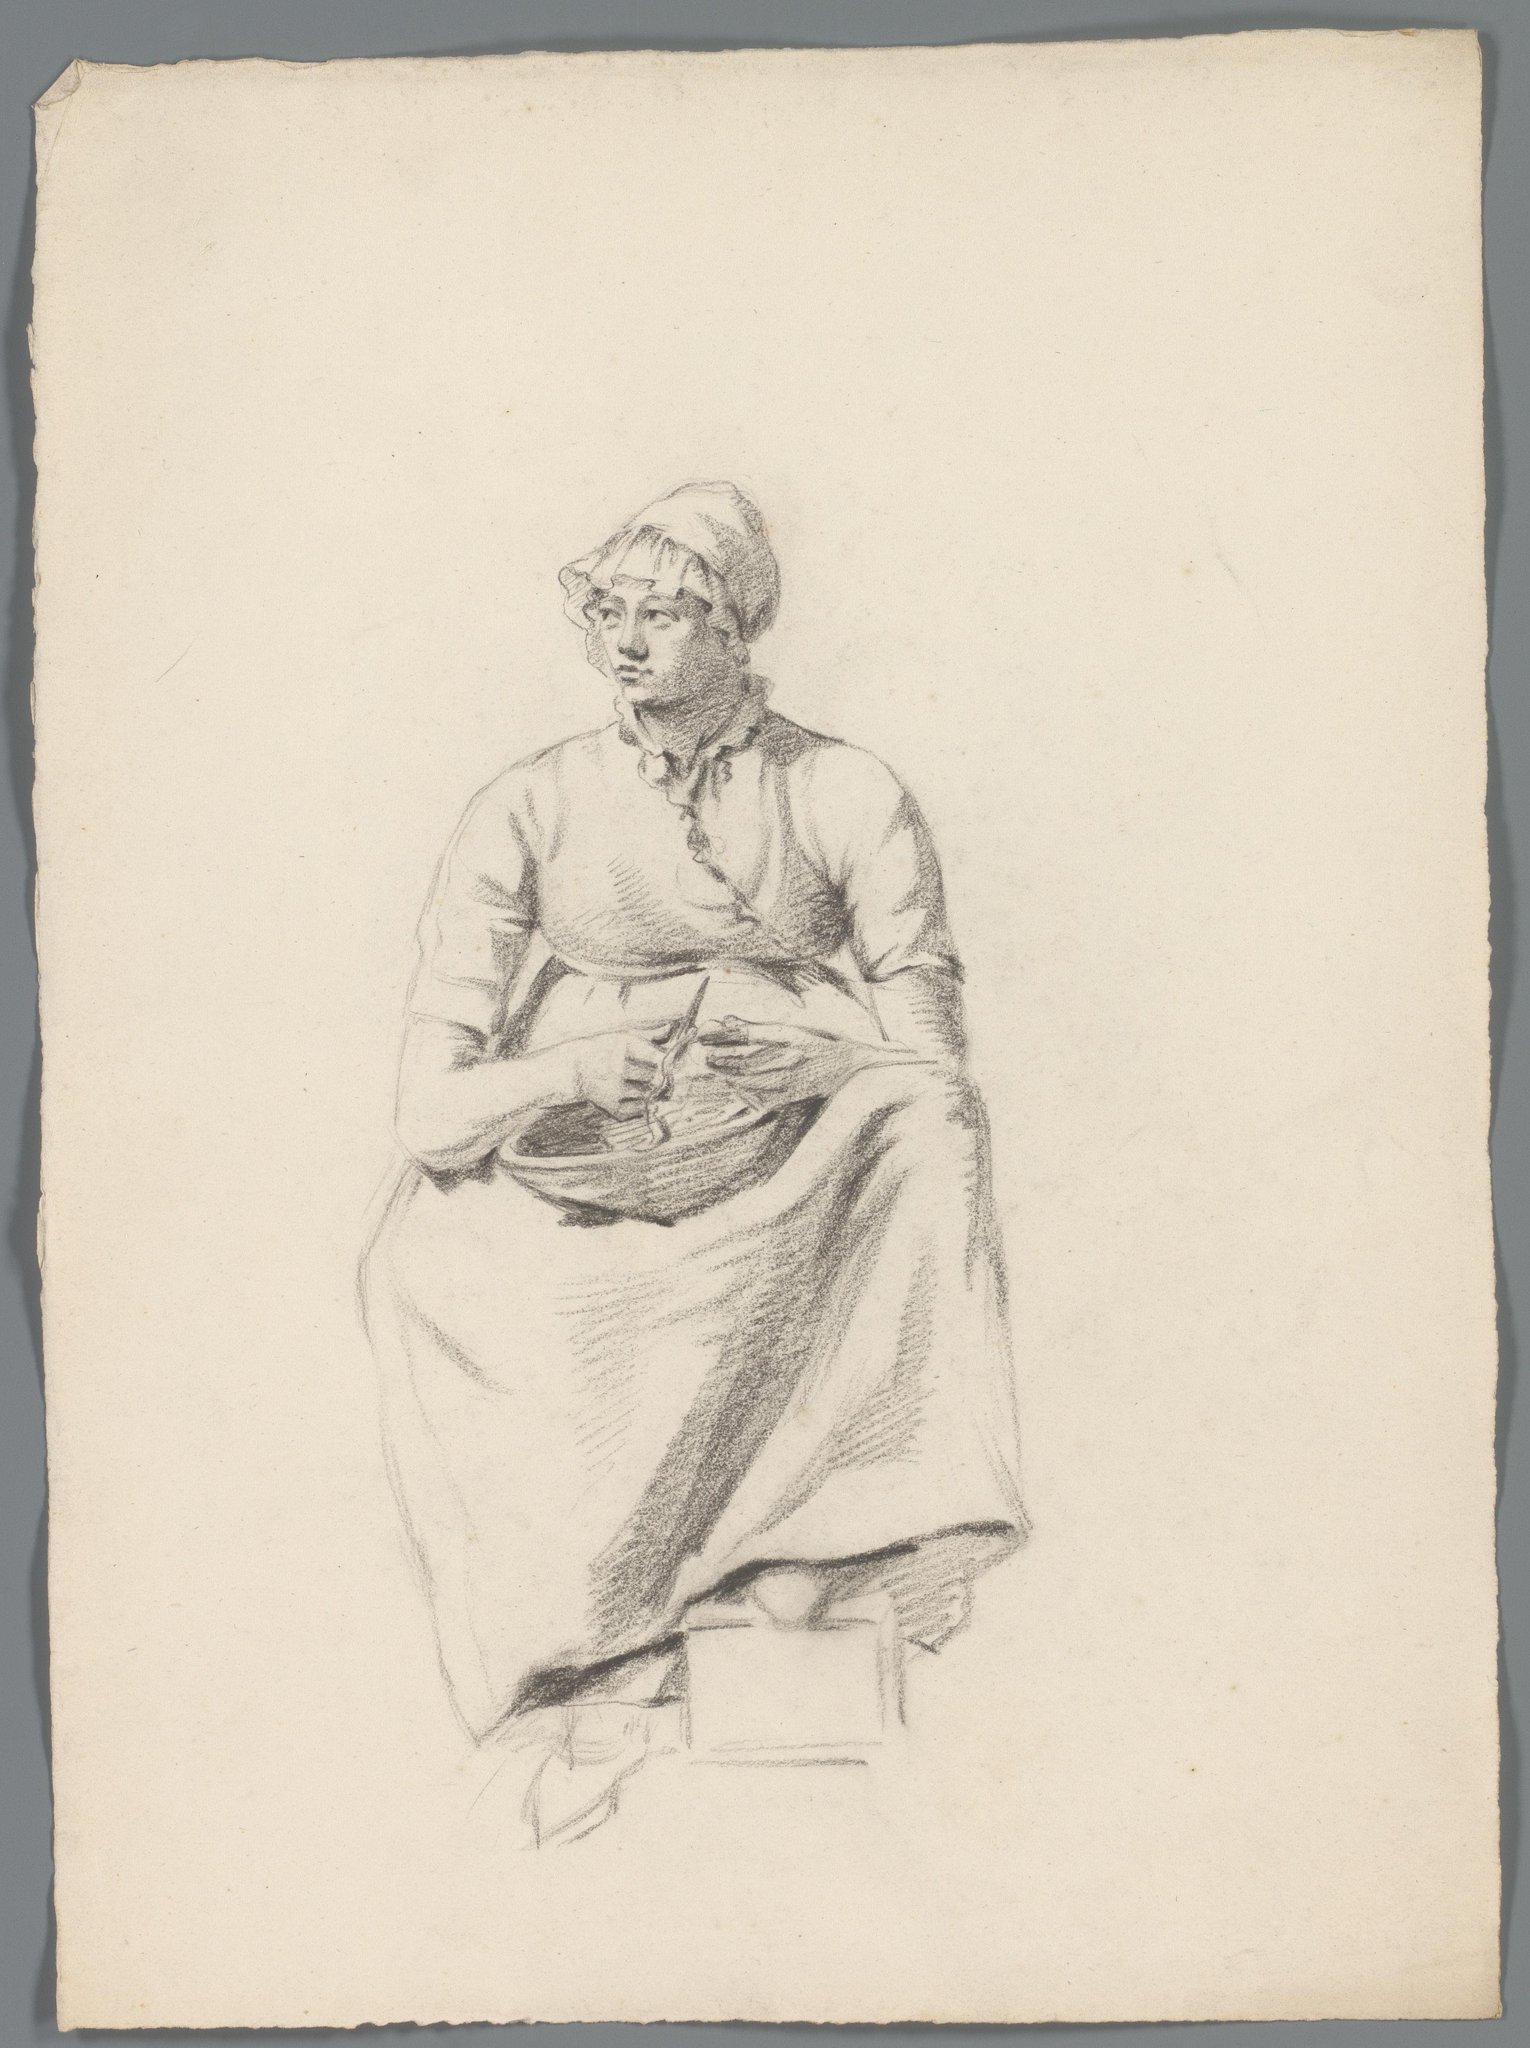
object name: drawing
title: Zittende vrouw die iets schilt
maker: Anonymous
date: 1820-1830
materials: chalk, paper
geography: the hague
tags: adult woman, sitting figure - aa - female human figure, cleaning fruit, e.g. peeling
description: Tekeningen waarschijnlijk ontstaan bij het Haagse kunstgenootschap ‘Tot Nut der Tekenkunst’, waar twee keer per week tekenavonden werden georganiseerd met geklede modellen.